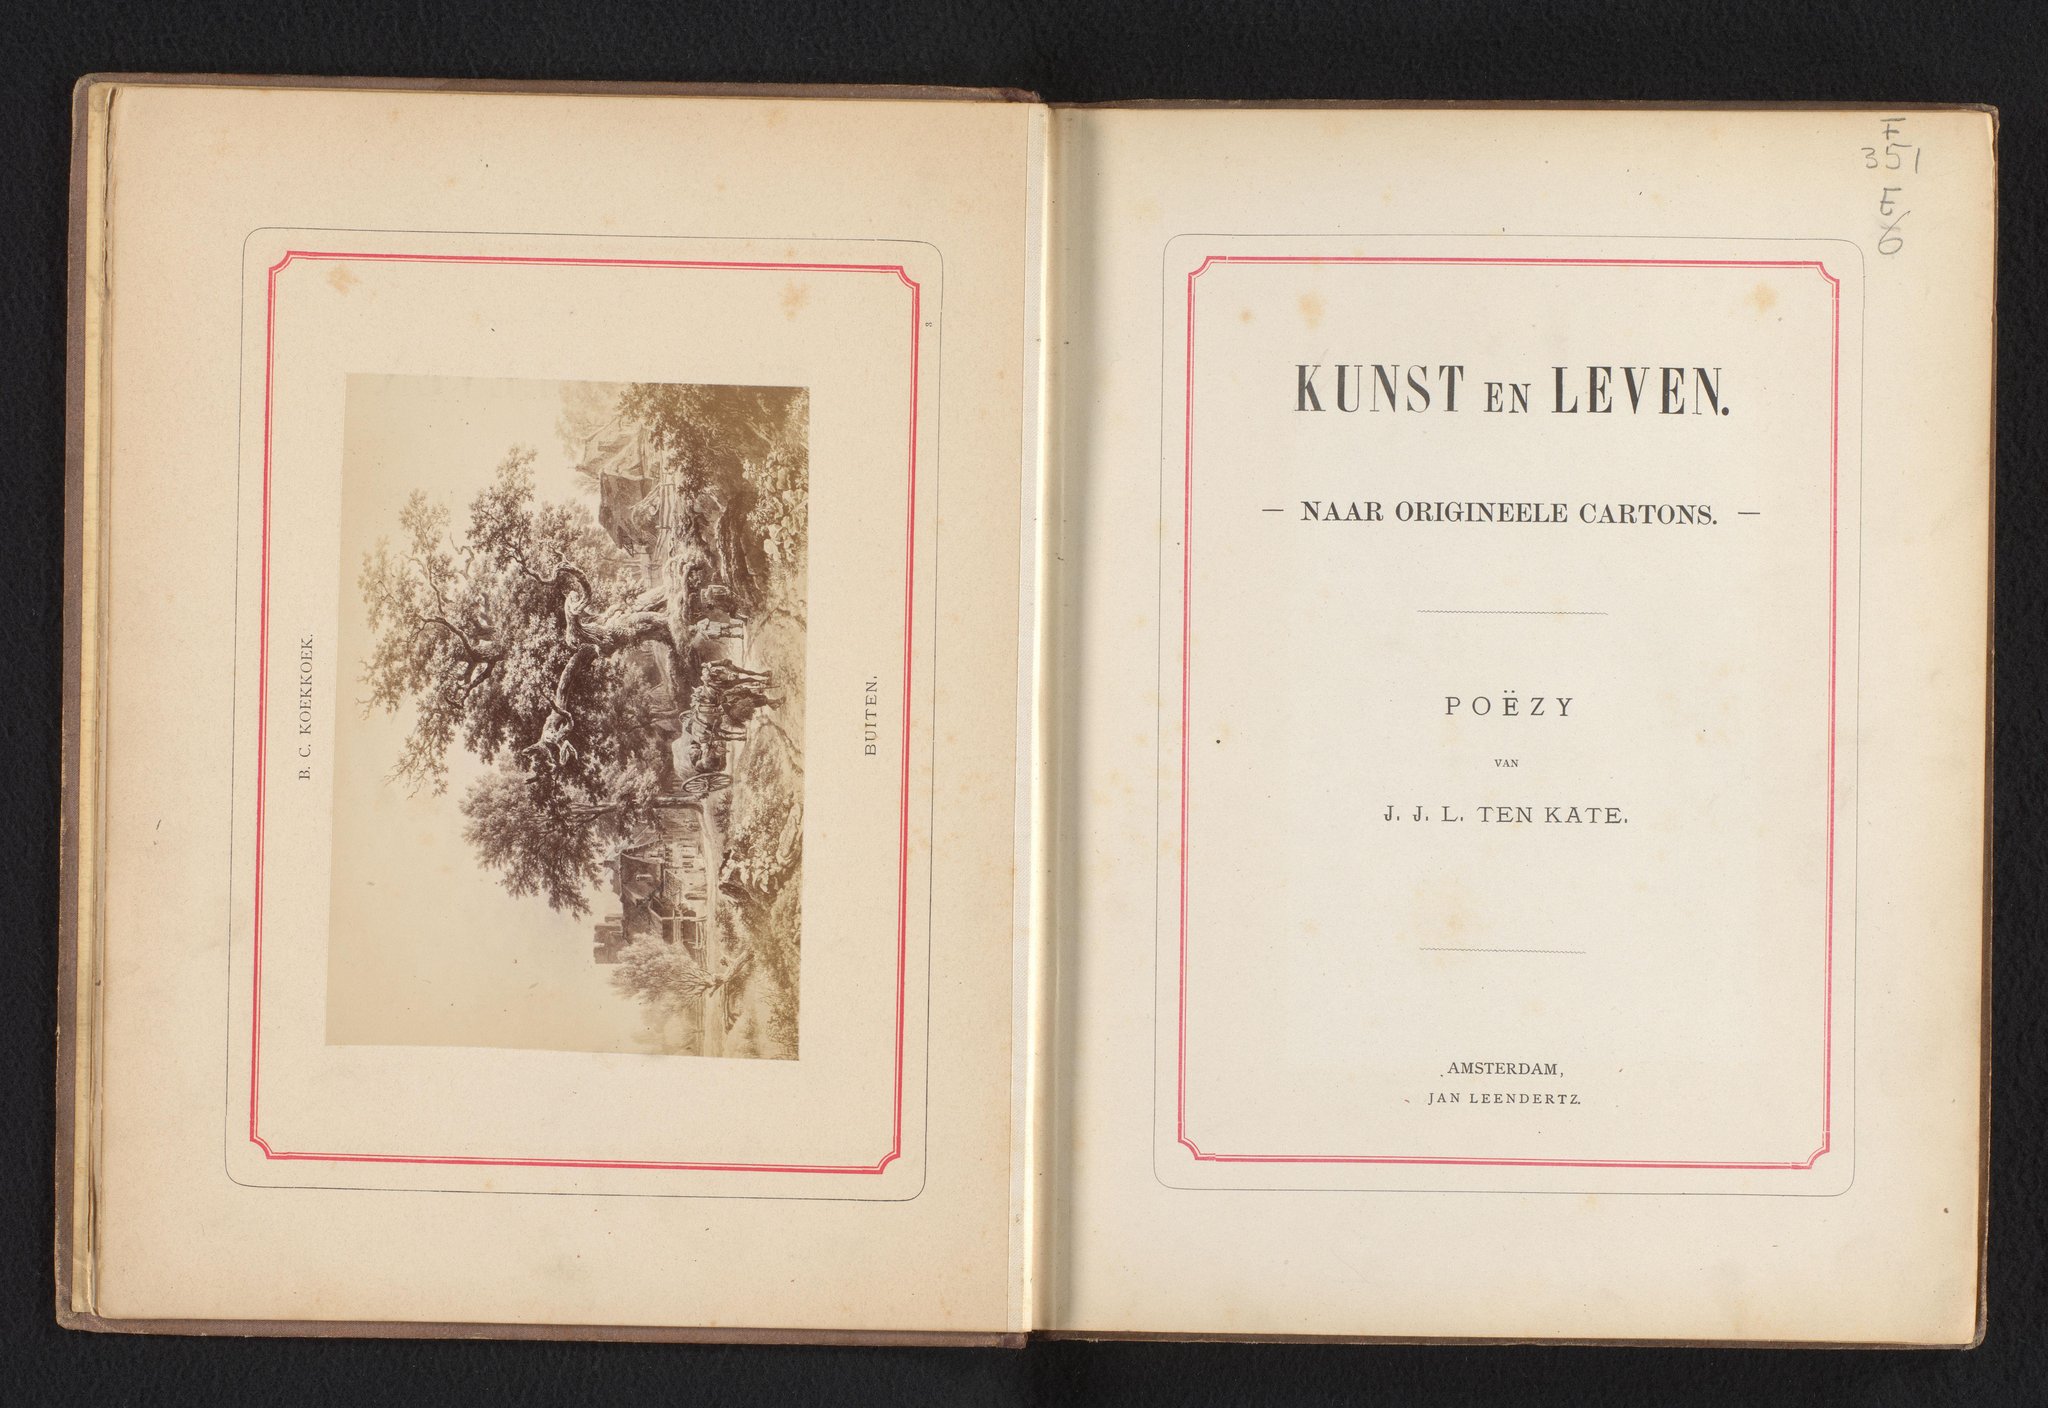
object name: page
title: Buiten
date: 1865-1878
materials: paper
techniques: albumen print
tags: farmers